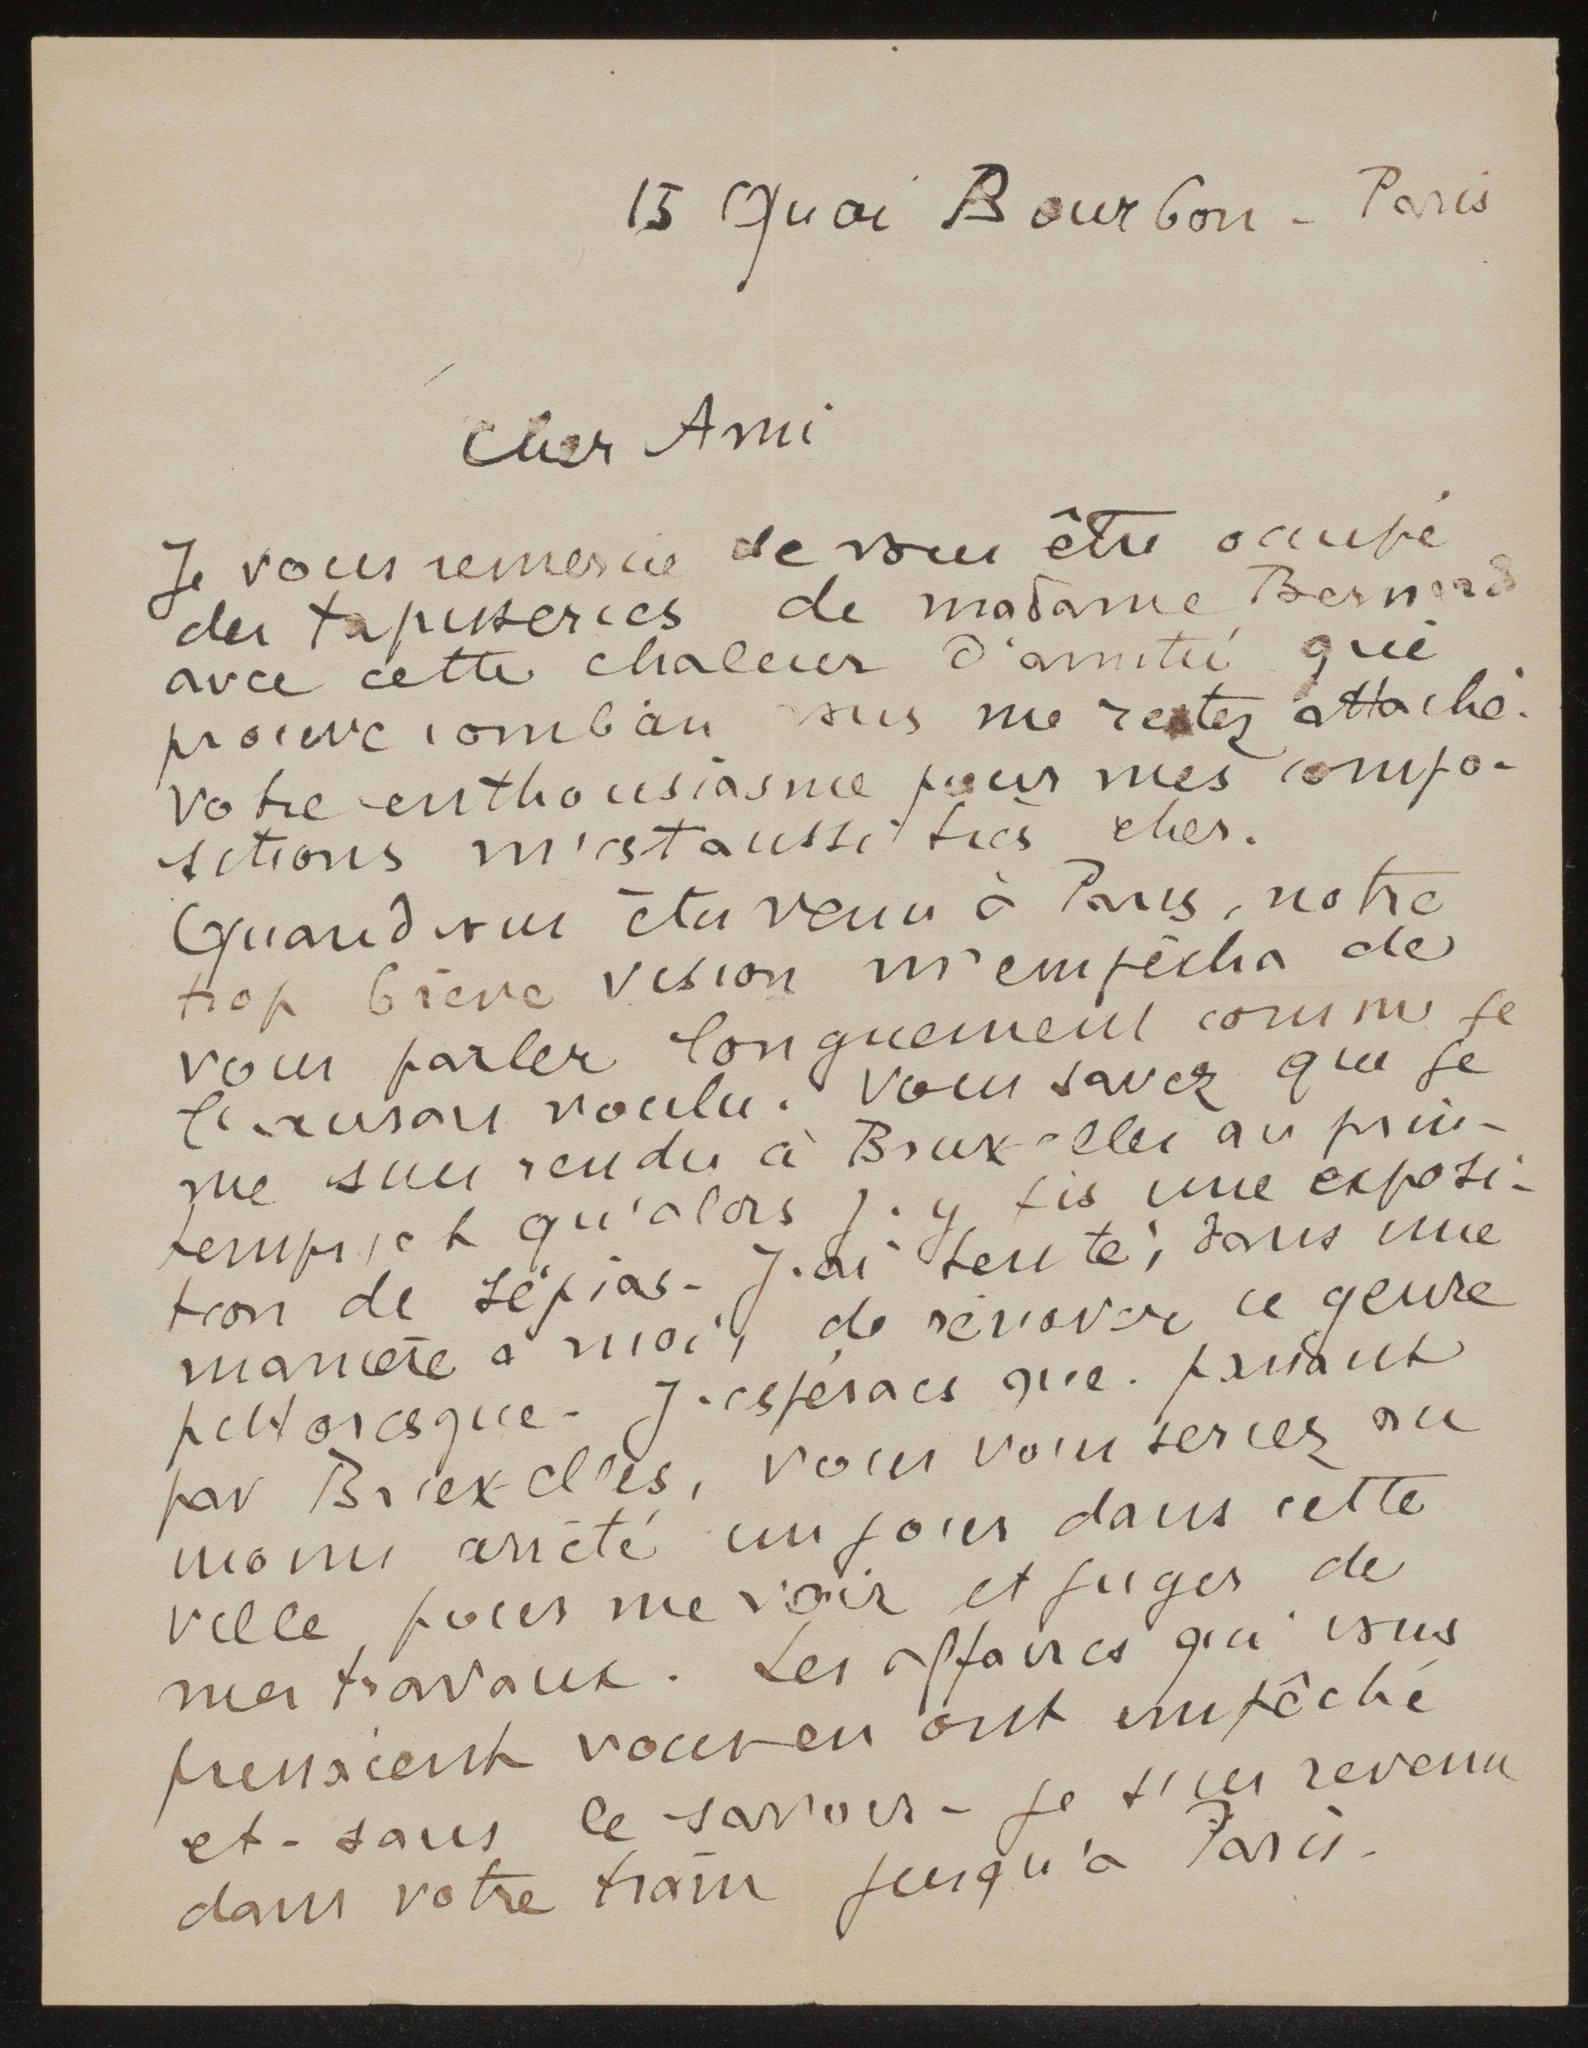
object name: letter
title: Brief aan Andries Bonger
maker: émile bernard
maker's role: print maker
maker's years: 1868-1941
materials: ink, paper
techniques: pen, writing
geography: paris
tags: michel ange bernard, amsterdam, andries bonger, art trade, art shop, drawing, applied arts, arts and crafts; industrial design, family life, exhibition ~ art, money, netherlands, italy, brussels, paris, naples, rome